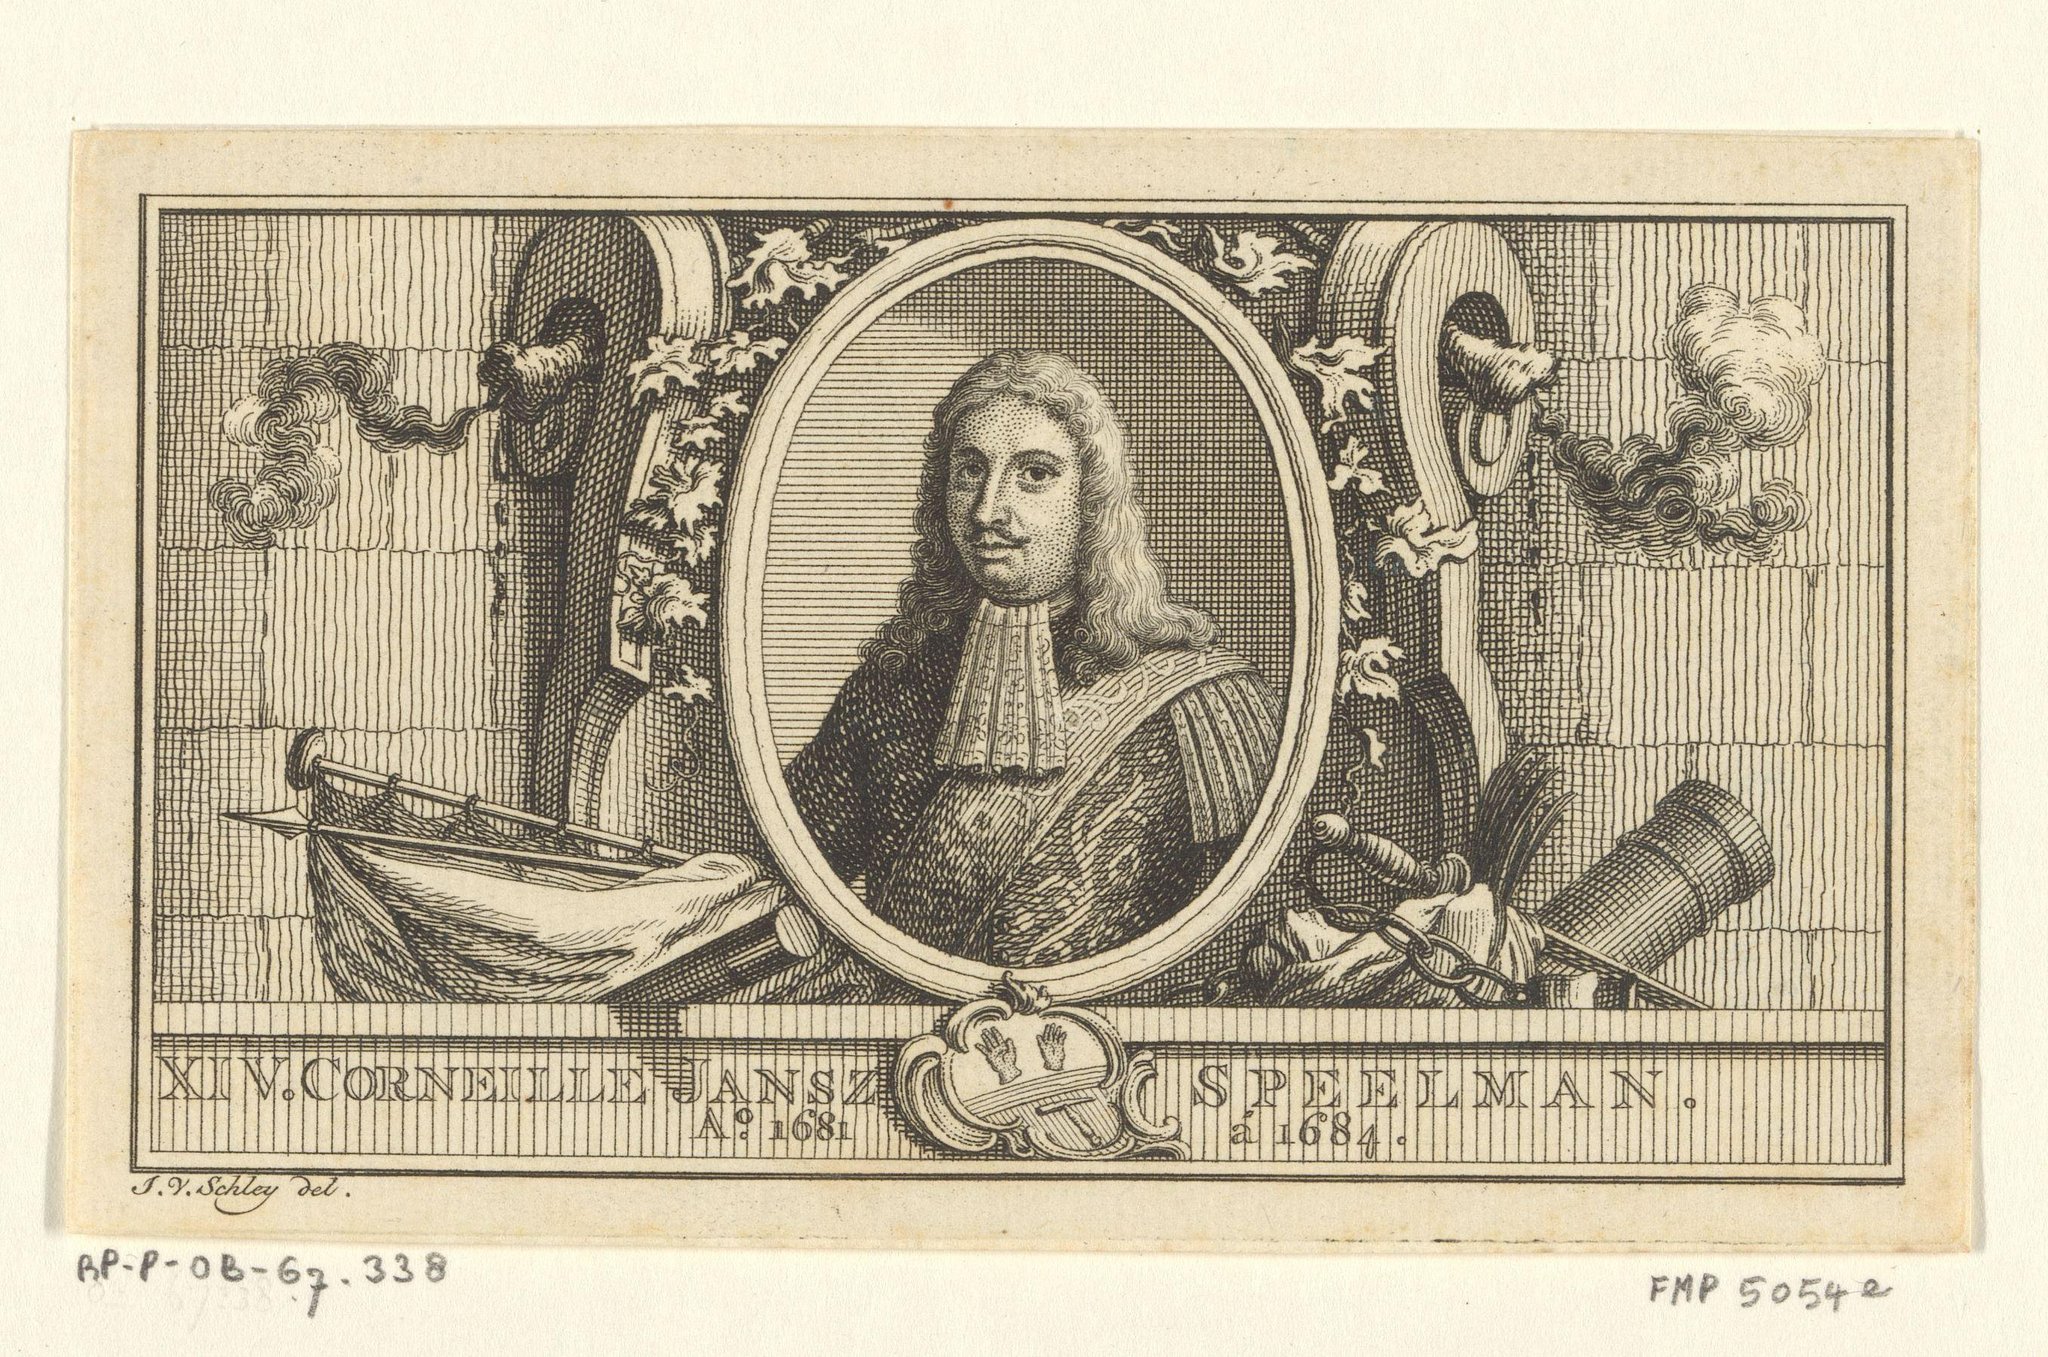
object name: print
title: Portret van Cornelis Speelman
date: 1763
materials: paper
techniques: engraving, etching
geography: the hague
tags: rotterdam, batavia, weapons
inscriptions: collector's mark: Lugt 964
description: Ook gebruikt als illustratie in: Du Bois, J.P.I. Vies des gouverneurs généraux avec l'abrégé de l'histoire des établissemens hollandais aux Indes Orientales. Den Haag: Pierre de Hondt, 1763, p. 235.